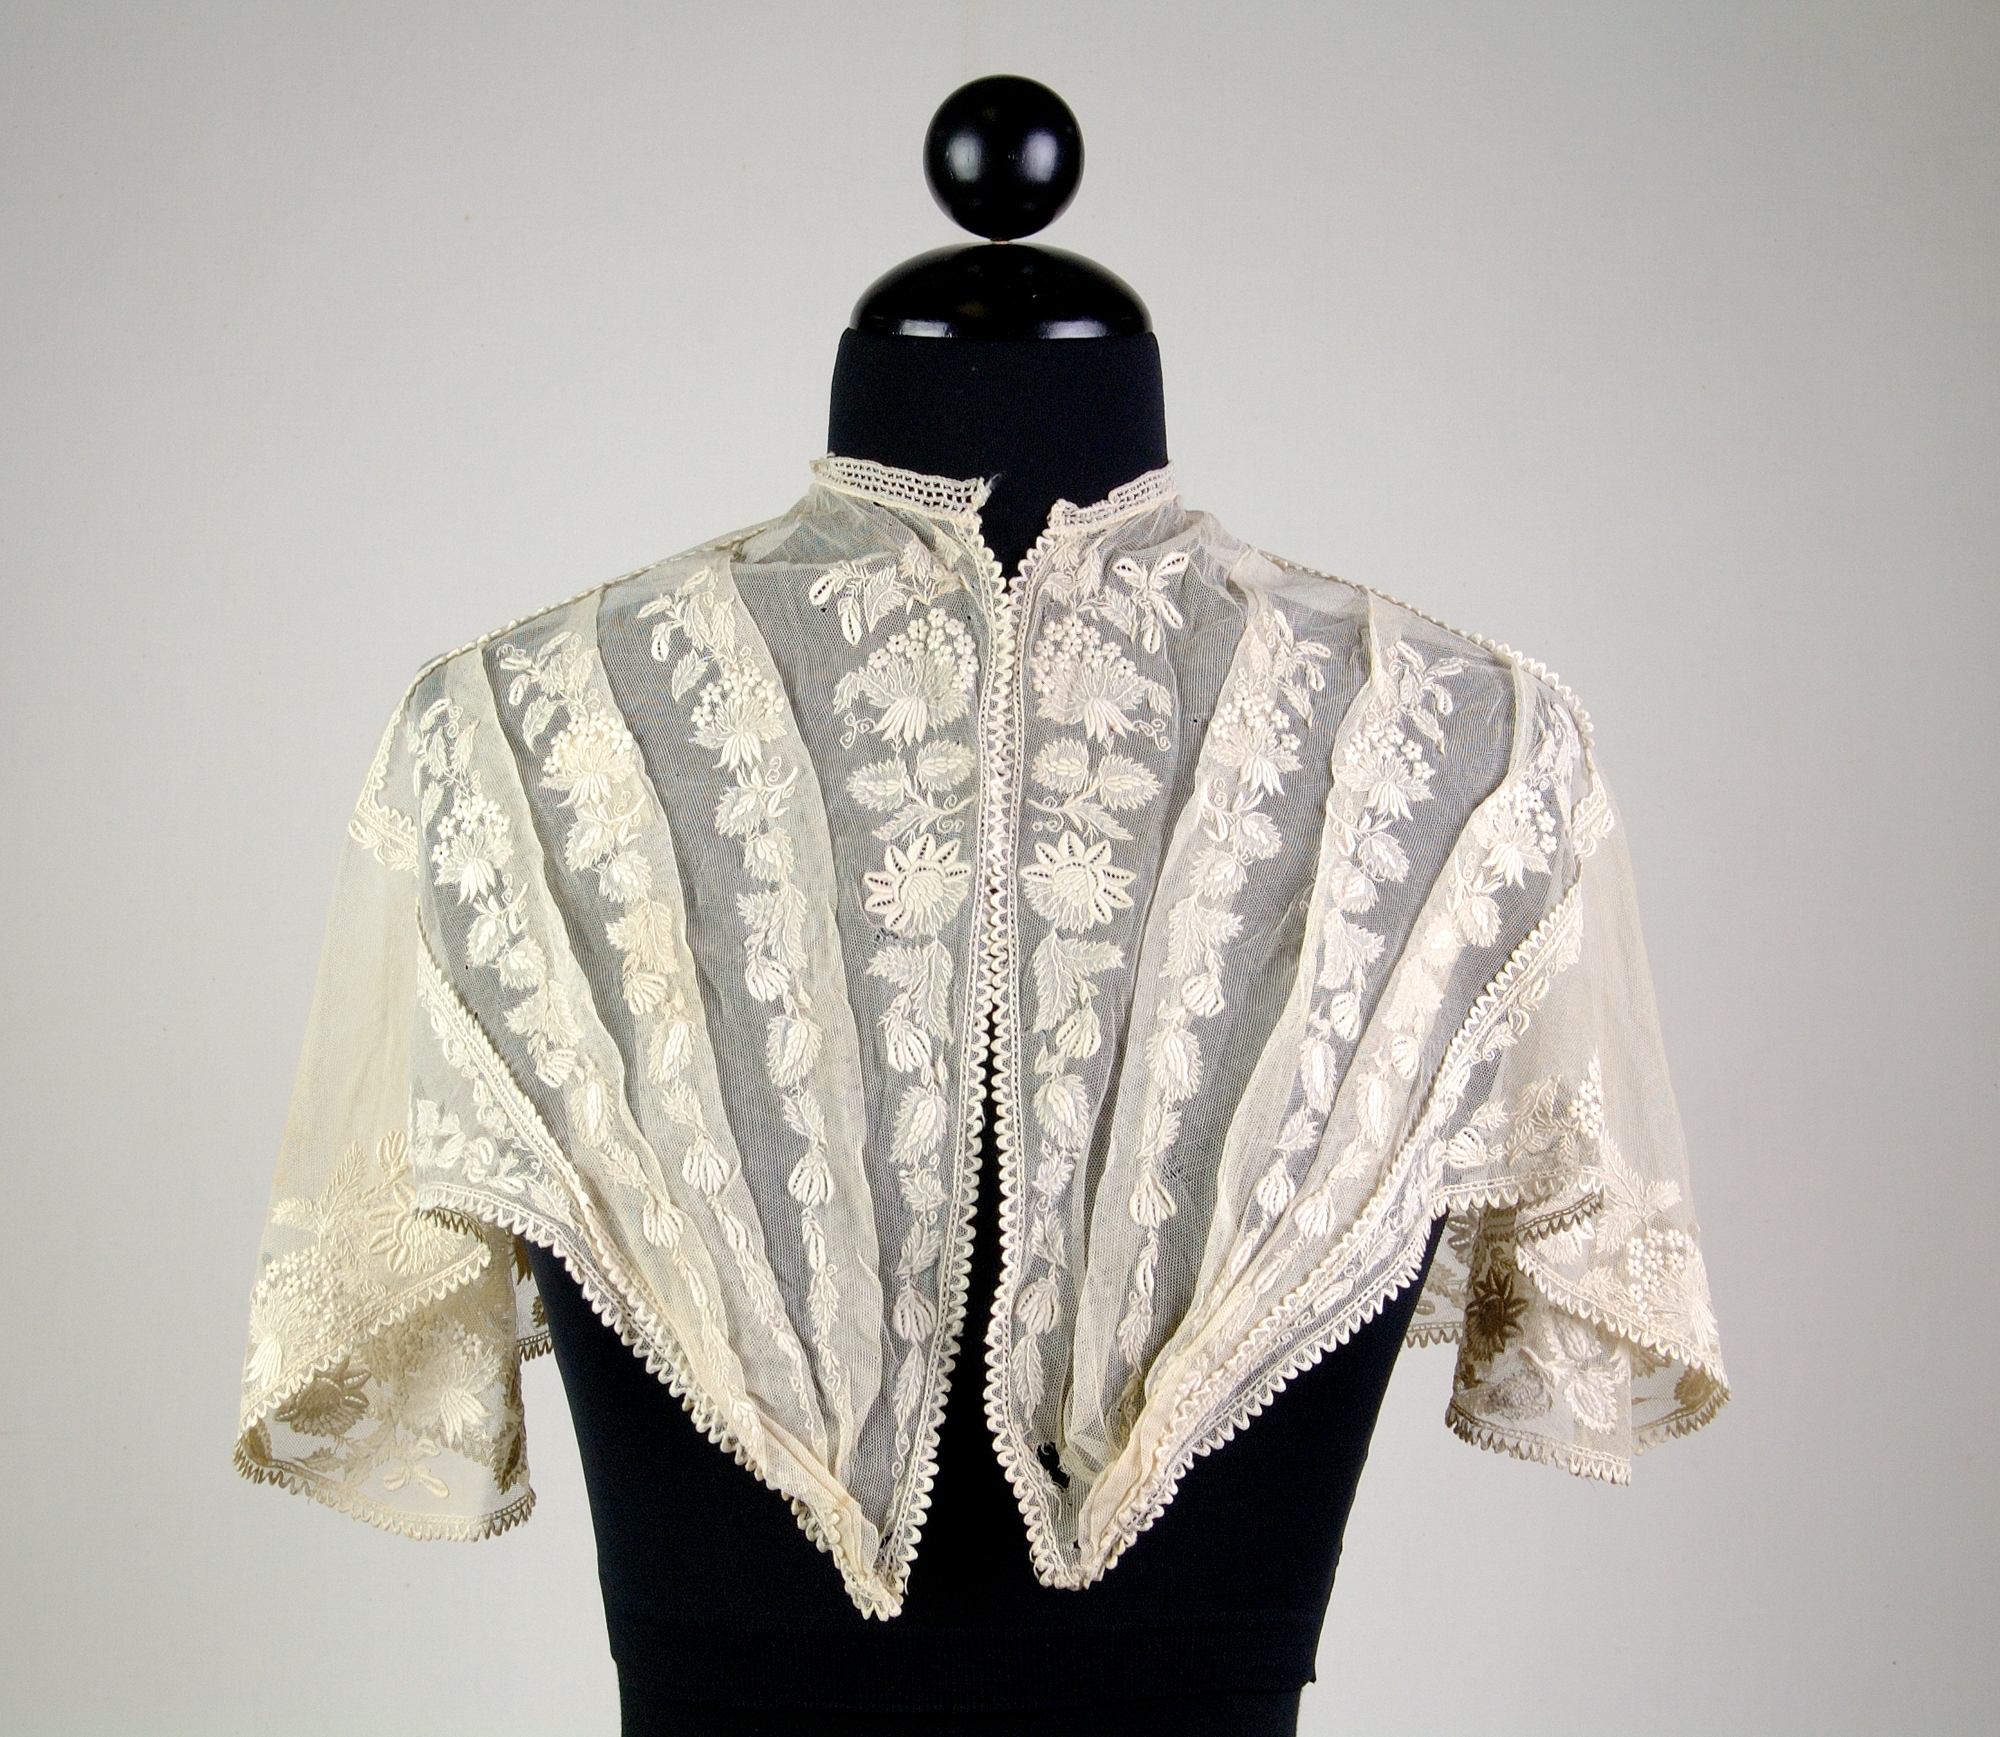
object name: pelerine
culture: american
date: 1830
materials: cotton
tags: flowers